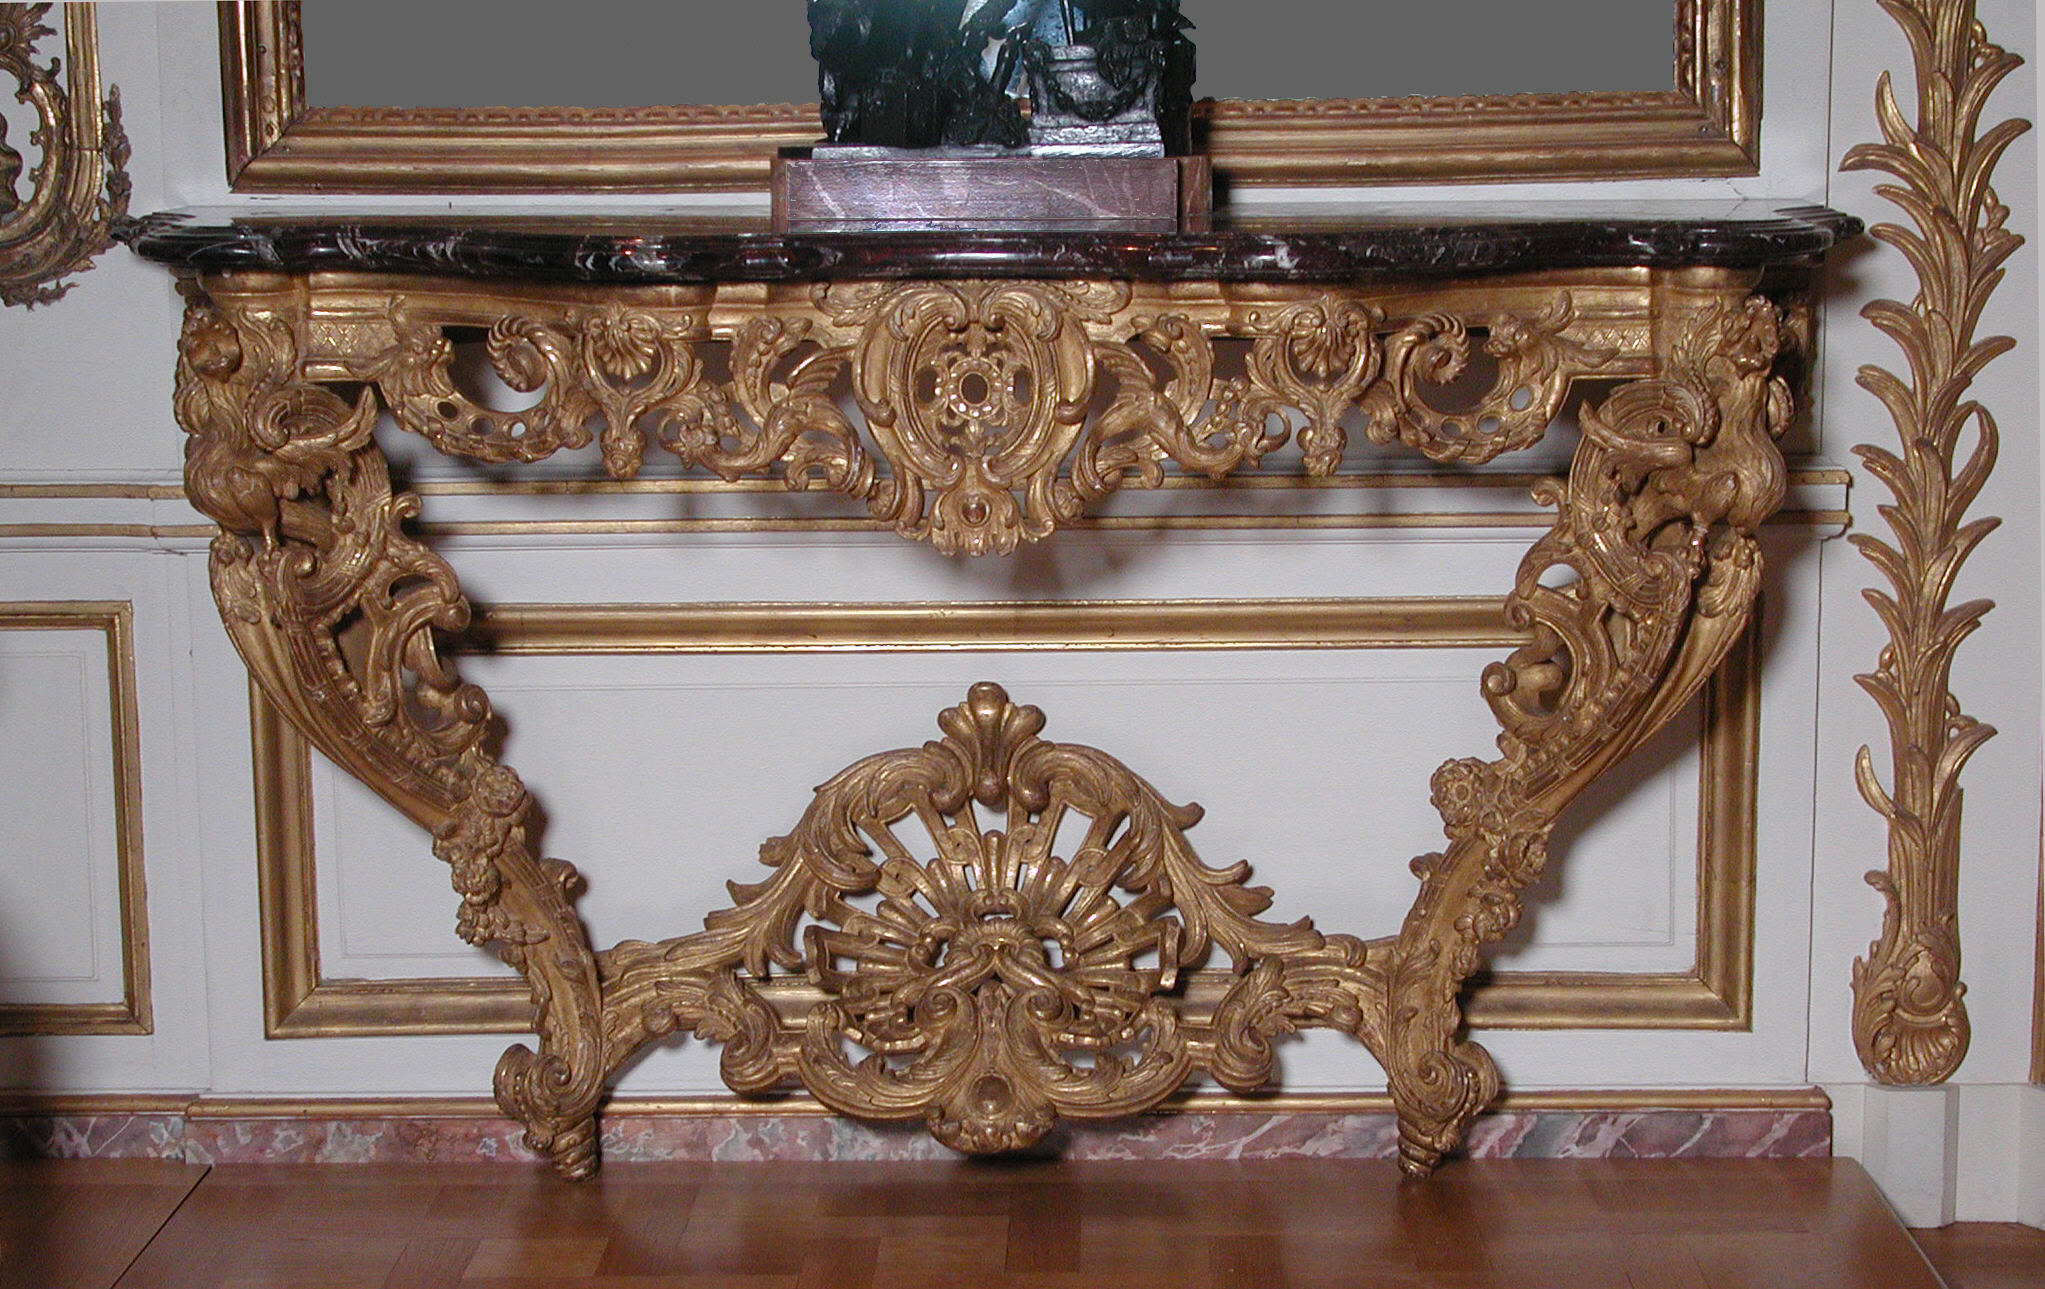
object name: console table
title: Console table (one of a pair)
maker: françois rournier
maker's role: maker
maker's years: 1716-1746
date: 1735-1740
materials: marble, wood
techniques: carving, gilding